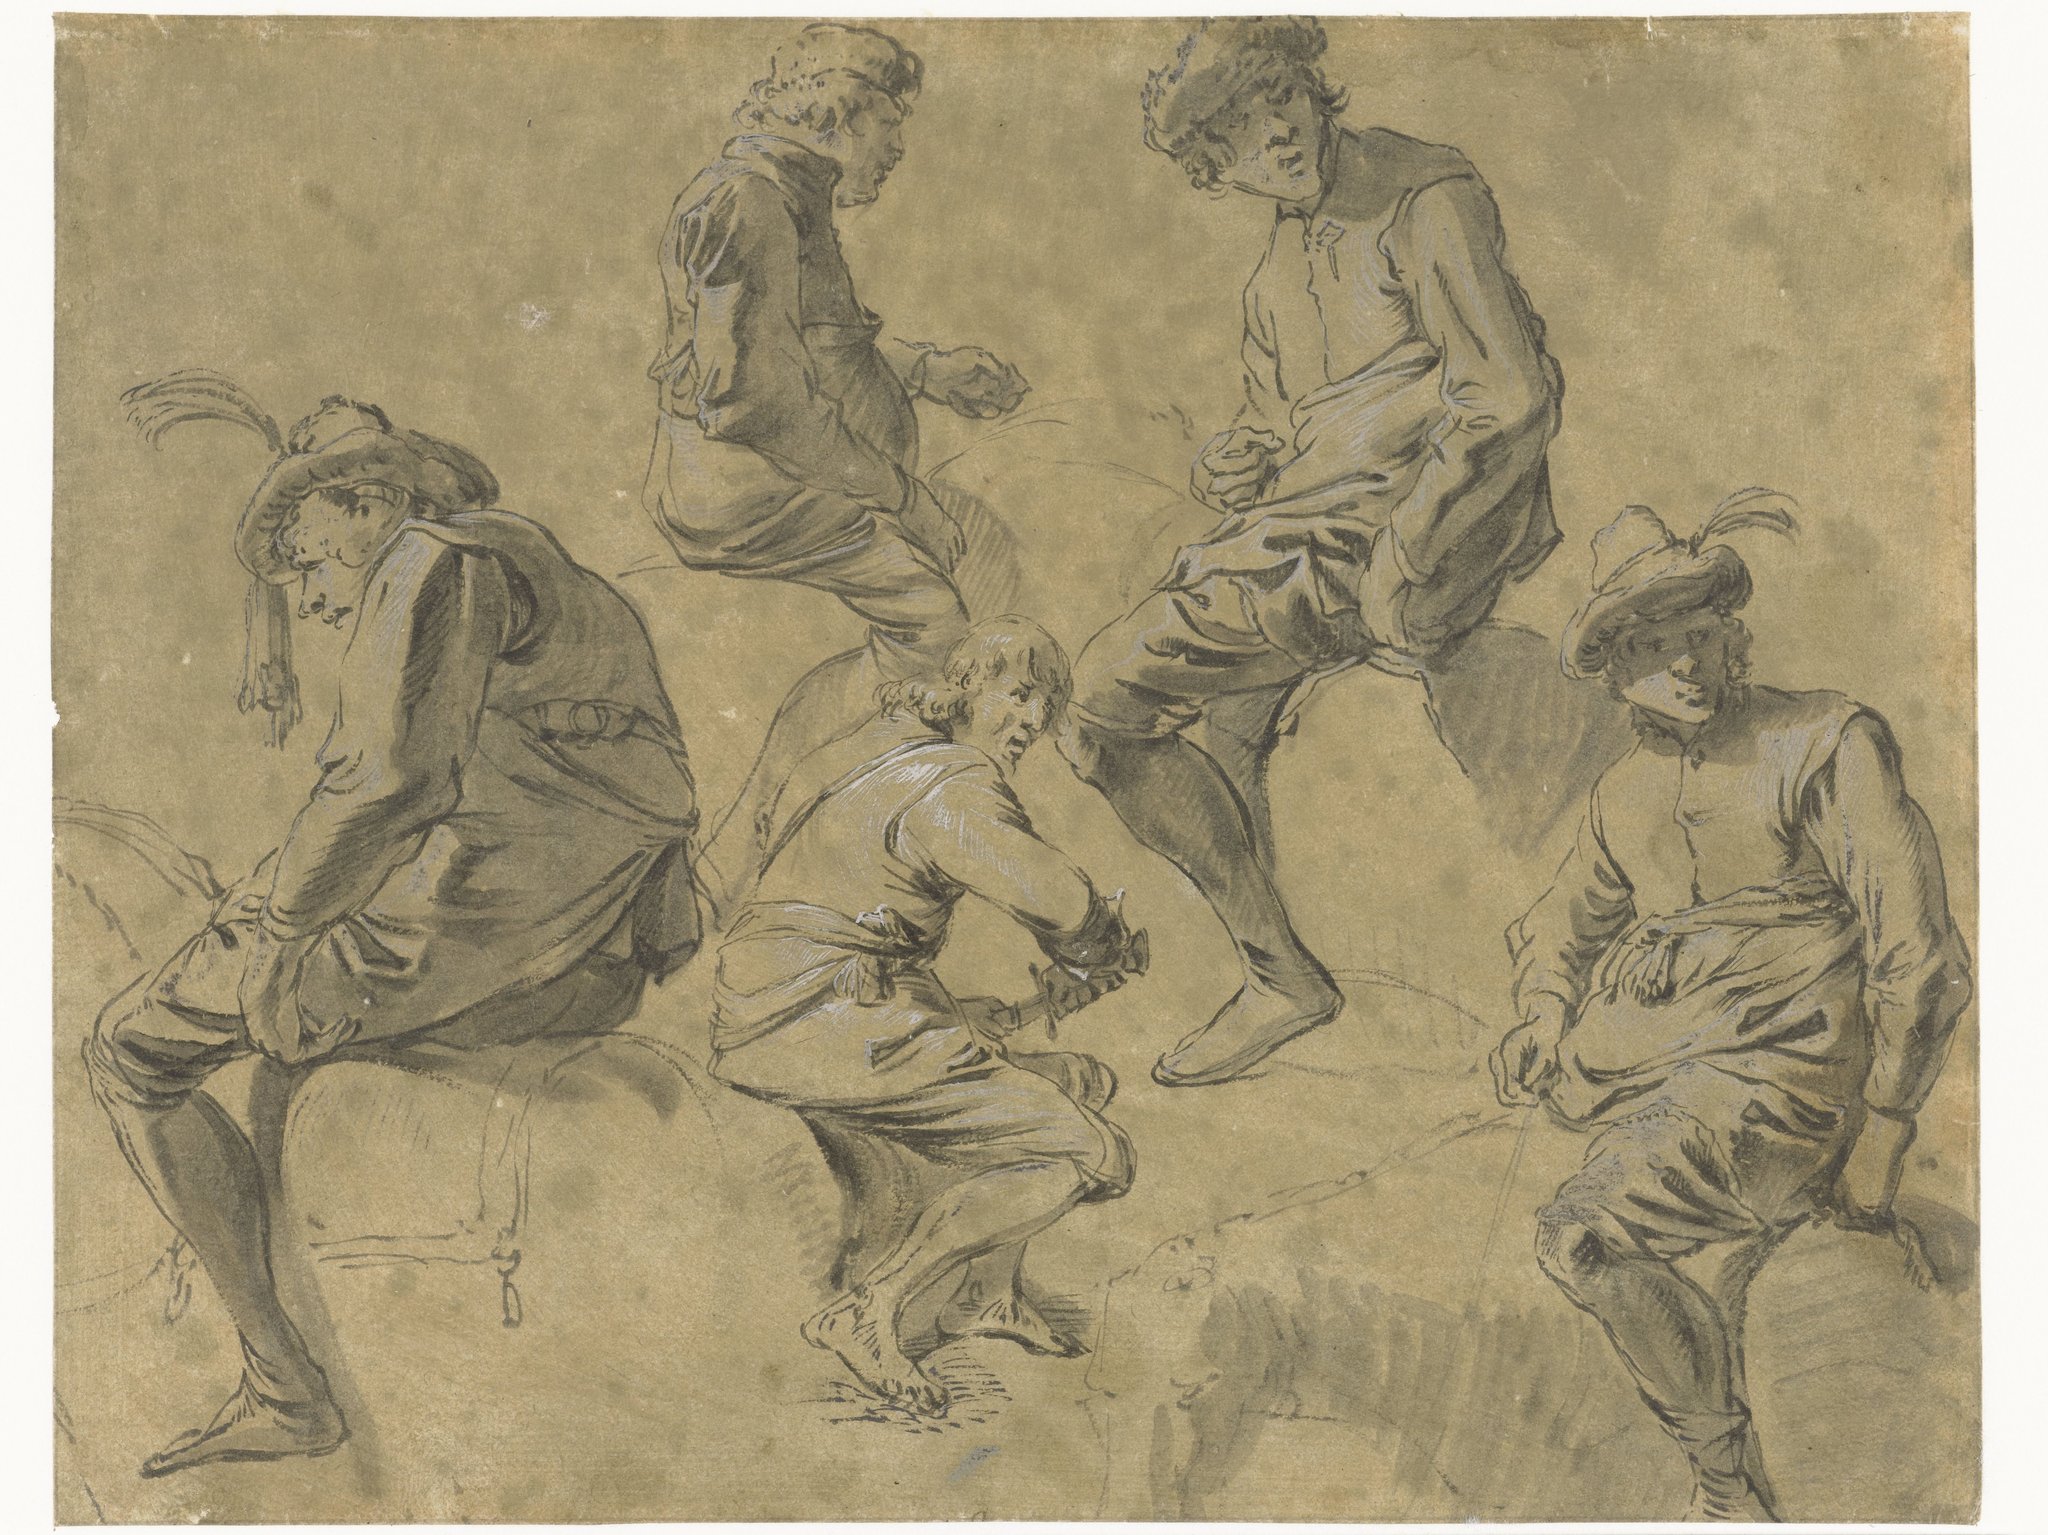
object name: drawing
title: Studieblad met vier mannen te paard en een op een steen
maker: leonaert bramer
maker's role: draughtsman, painter, print maker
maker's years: 1596-1674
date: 1606-1674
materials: paint, ink, paper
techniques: brush, pen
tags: riding a horse, ass, or mule; rider, horseman, sitting figure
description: In twee rijen zijn vijf studies getekend van vier mannen te paard, bovenaan twee naar elkaar toegewend en onderaan beiden naar links, waartussen en vijfde studie van een man die op een steen zit en zijn sabel trekt.